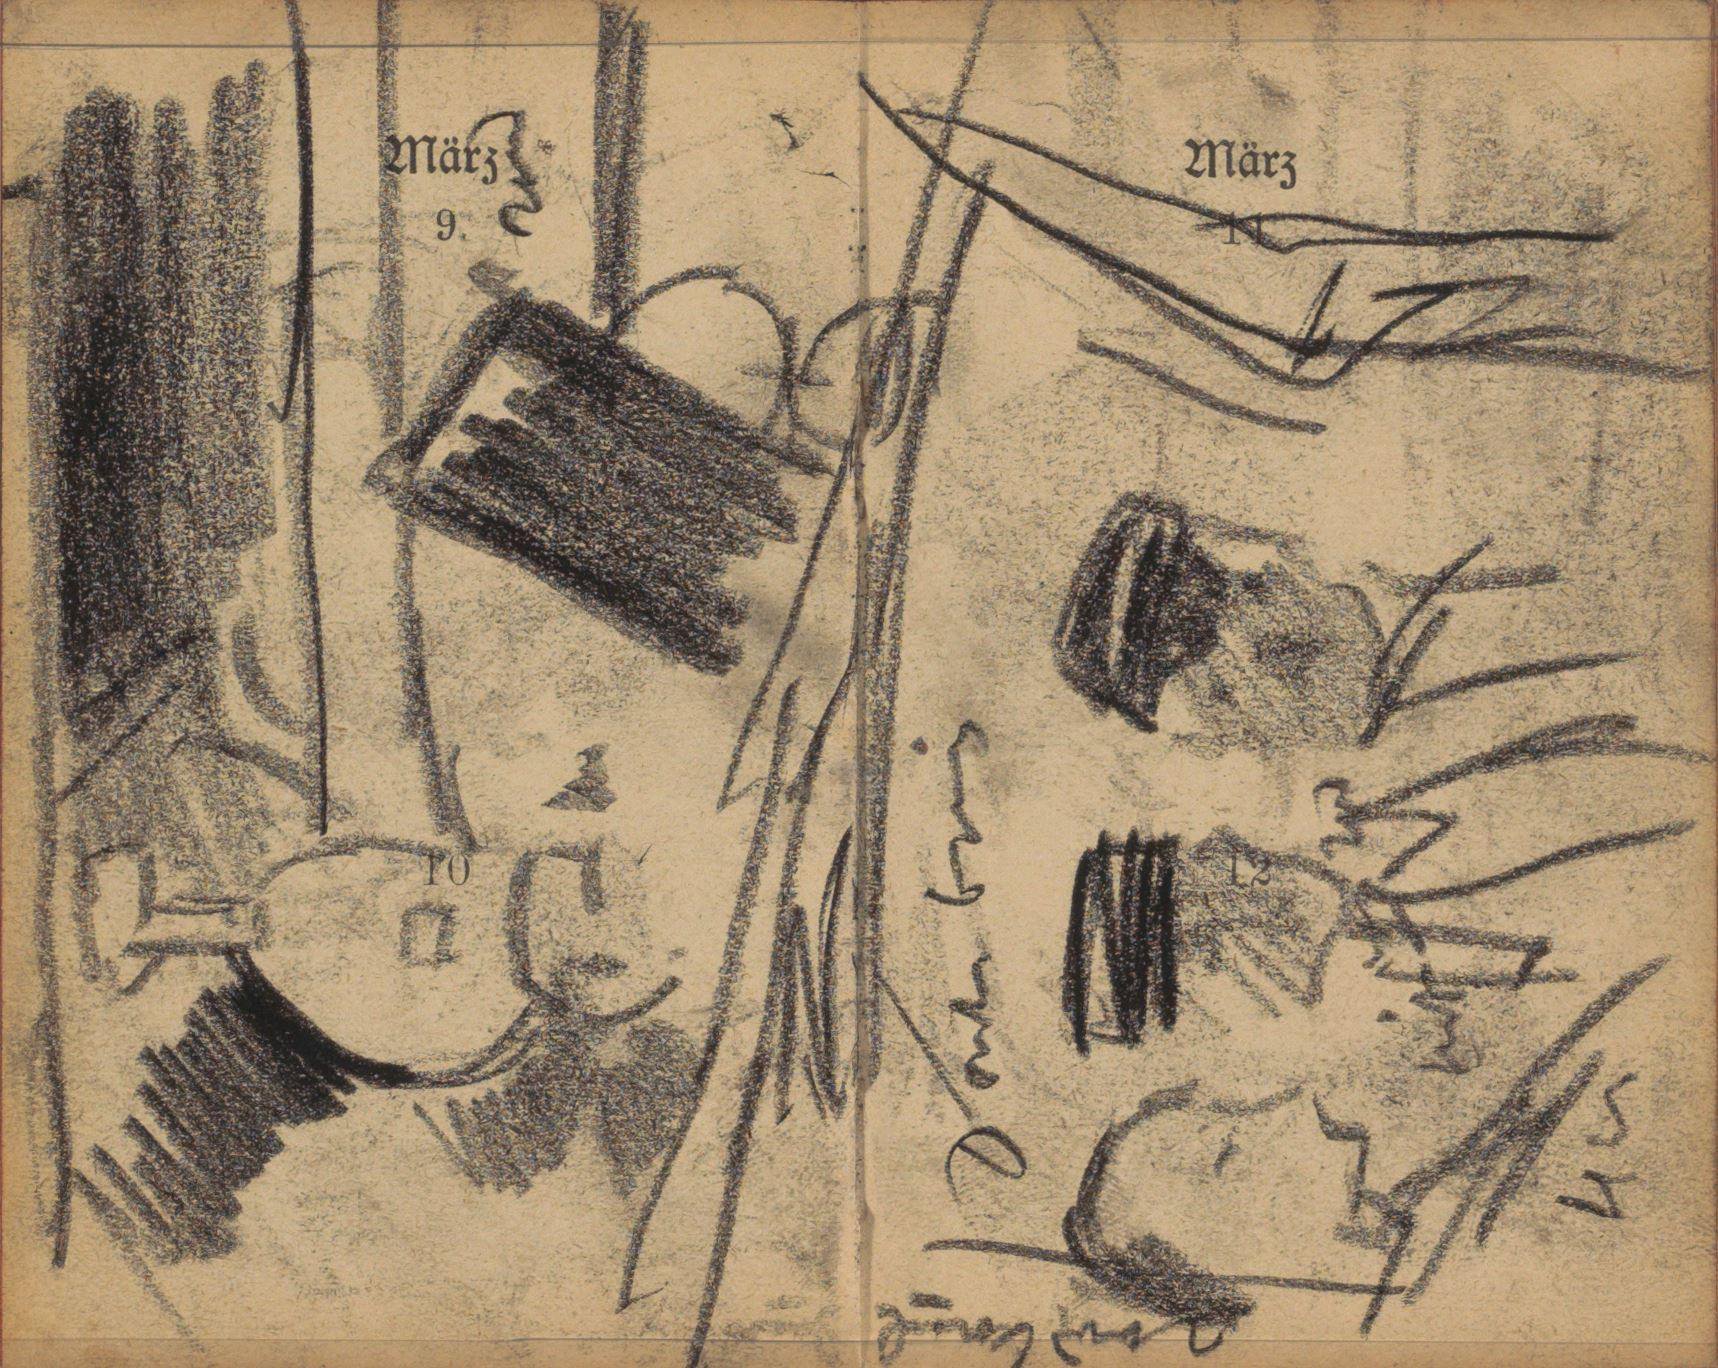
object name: sketchbook leaf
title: Drie figuren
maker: george hendrik breitner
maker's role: draughtsman, painter, print maker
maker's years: 1857-1923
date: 1893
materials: chalk, paper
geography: amsterdam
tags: adult woman, adult man, railway, train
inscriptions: kleurnotitie, handgeschreven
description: Op de achtergrond mogelijk een trein. Pagina 39 en pagina 40 uit een als schetsboek gebruikte agenda met 80 bladen.